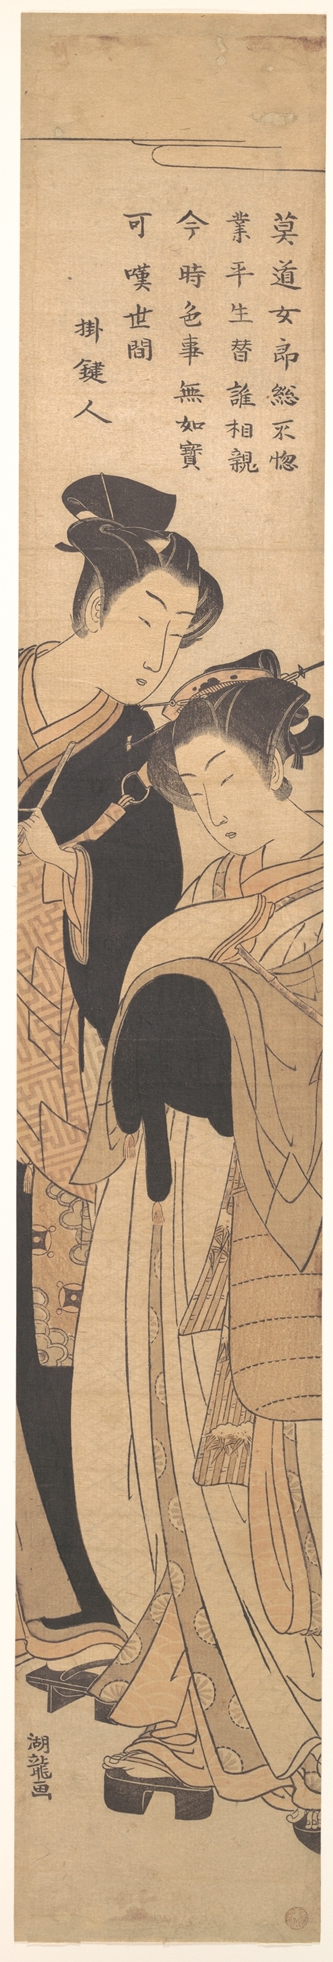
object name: print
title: Lovers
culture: japanese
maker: isoda koryūsai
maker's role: artist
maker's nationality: japanese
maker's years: 1735-1790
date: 1770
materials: ink, paper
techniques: woodblock print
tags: lovers